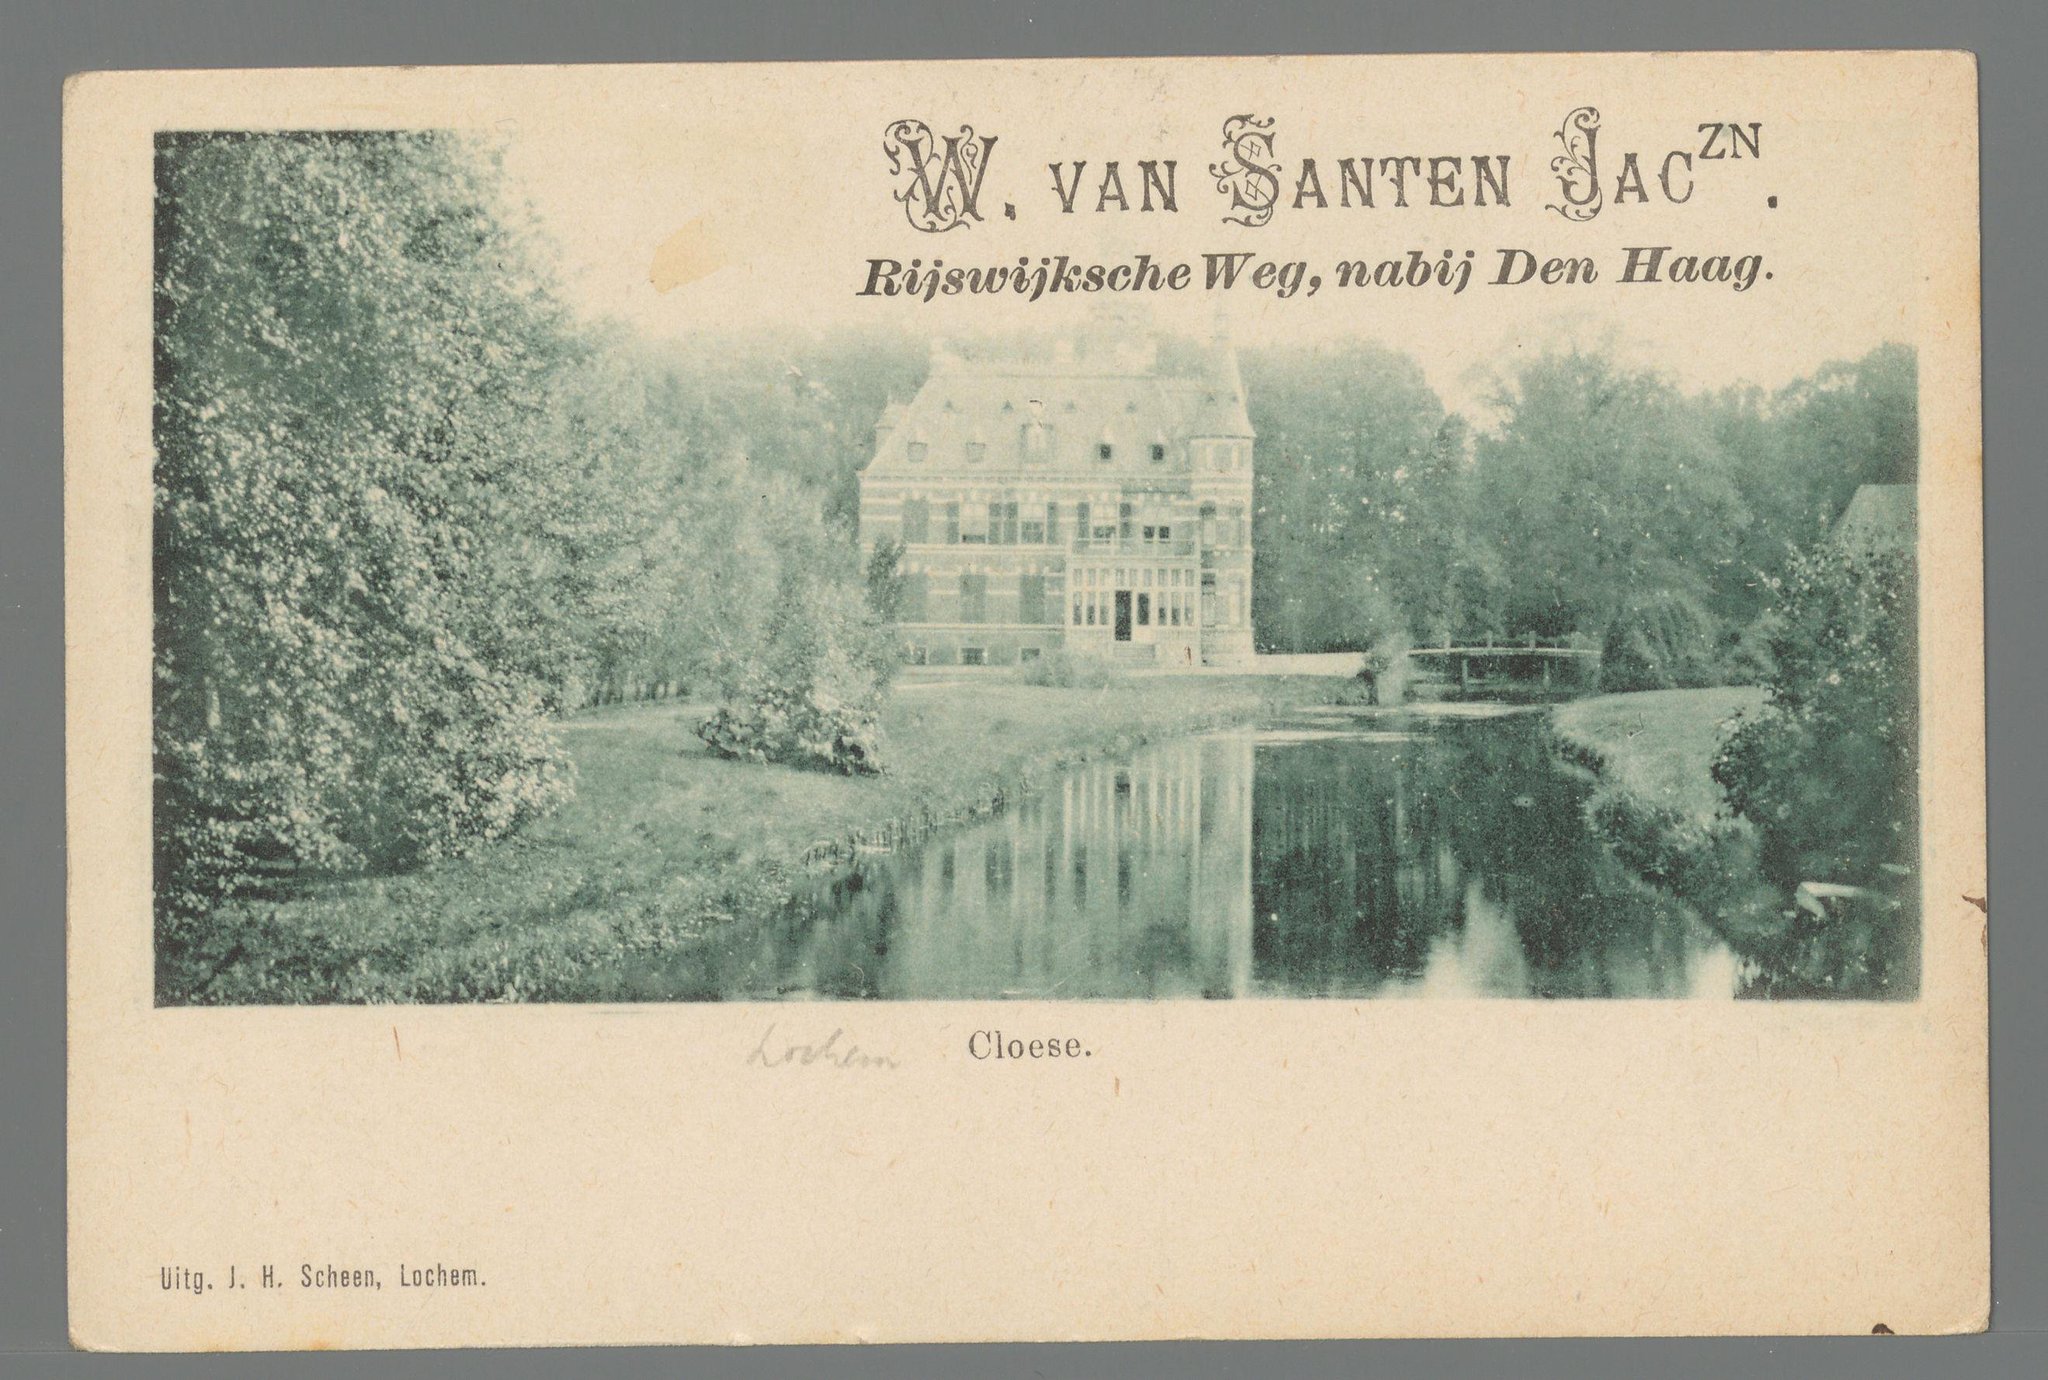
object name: ansichtkaart, prentbriefkaart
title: Cloese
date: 1892-1905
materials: cardboard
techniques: photograph, writing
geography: lochem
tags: castle, canal